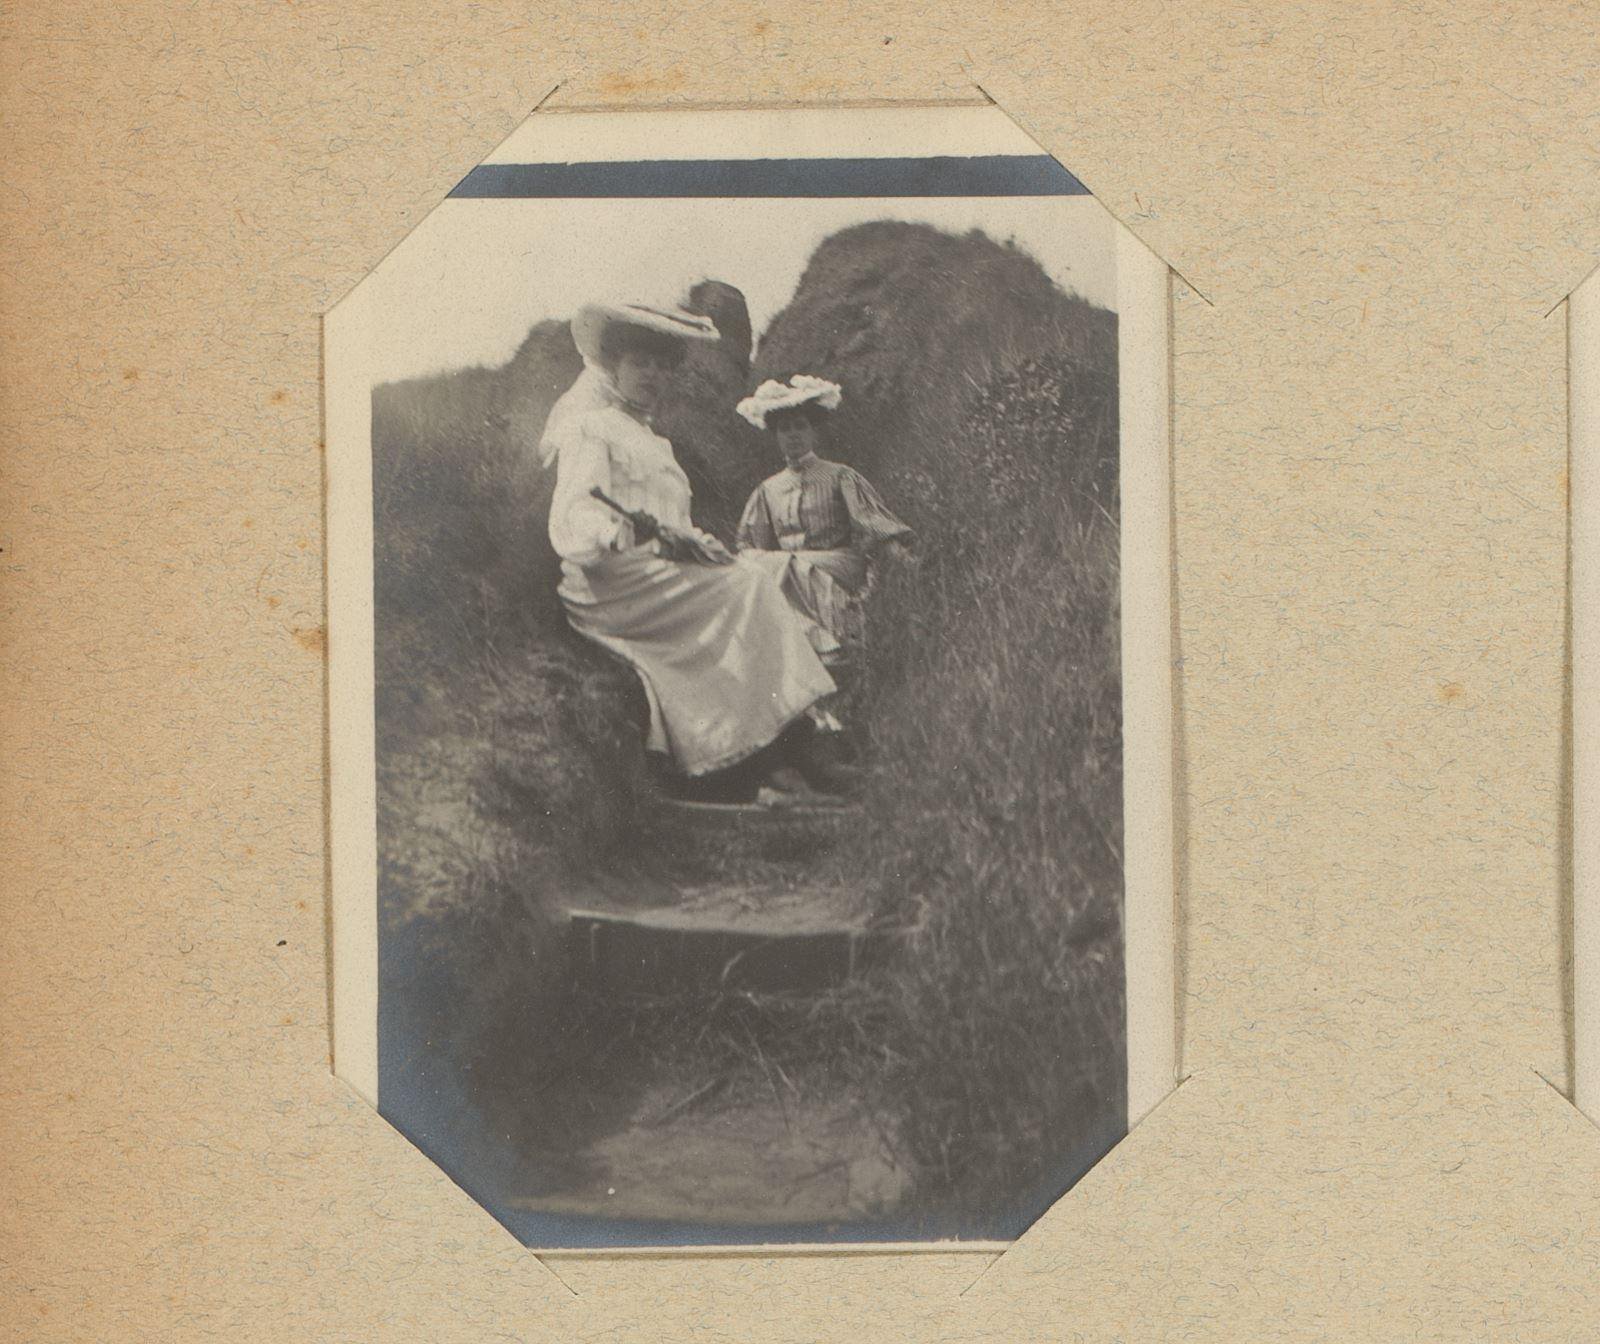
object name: album leaf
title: Twee vrouwen in de duinen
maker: Anonymous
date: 1897-1900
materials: paper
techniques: gelatin silver print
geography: france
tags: dunes (sea not visible); in the dunes, france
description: Over de foto is een ander negatief afgedrukt van een voorstelling van bomen.